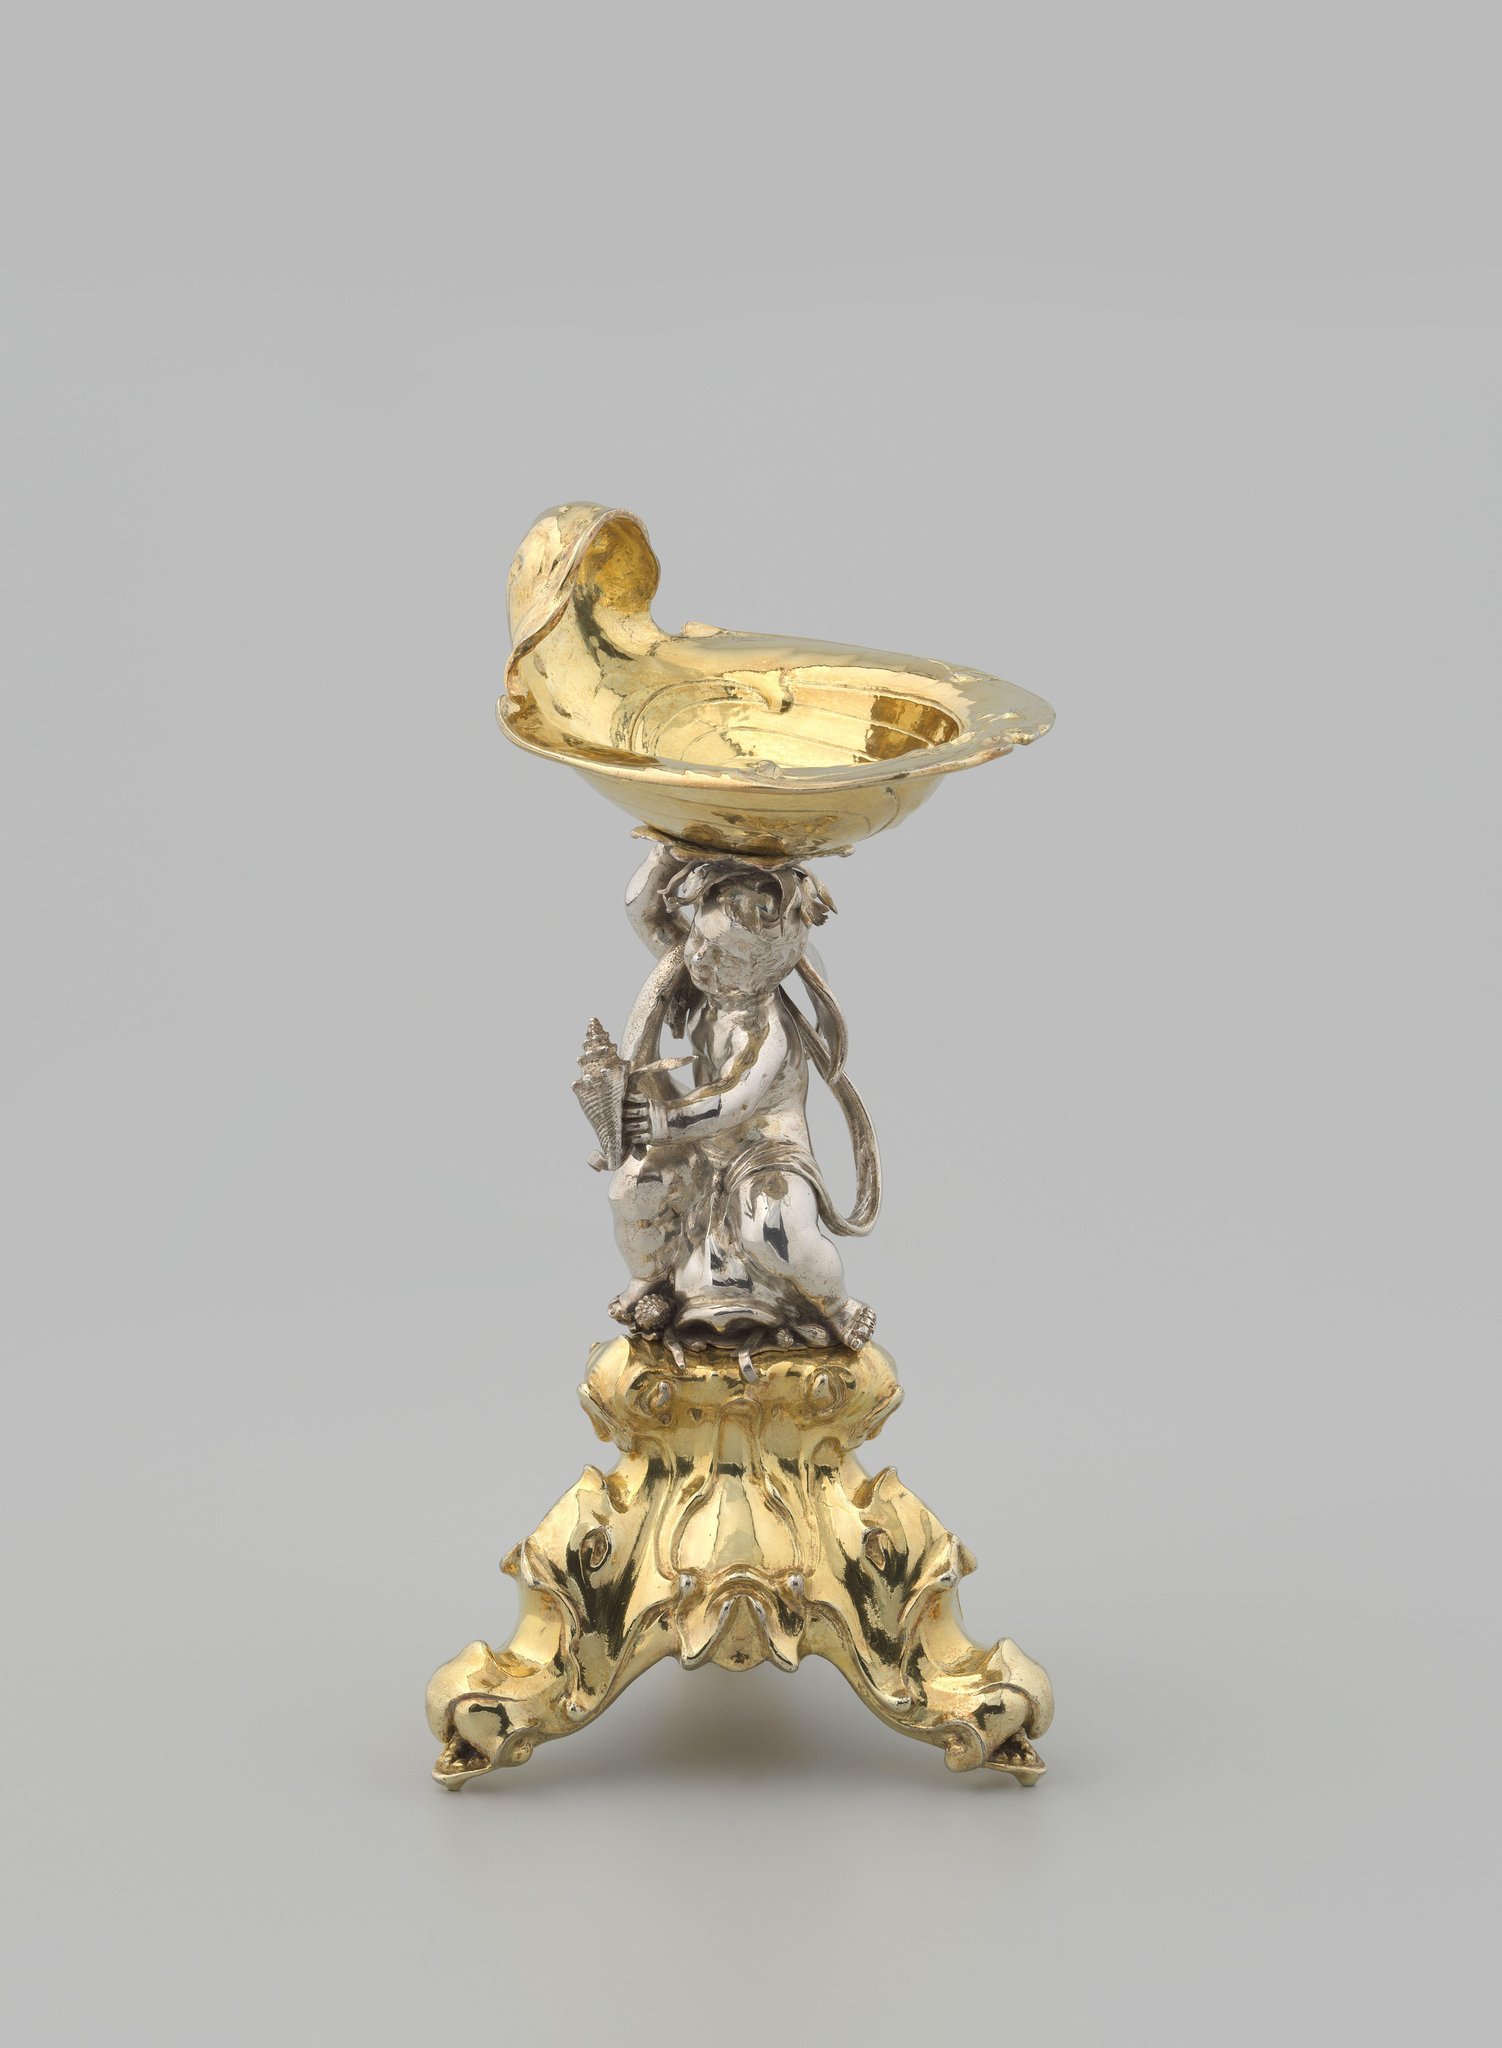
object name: salt condiment vessel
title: Two Salt Cellars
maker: johannes lutma (1584-1669)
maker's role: draughtsman, print maker, silversmith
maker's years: 1584-1669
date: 1639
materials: silver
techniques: gilding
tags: ornament derived from animal forms, dolphin ~ ornament, scallop, shell ~ ornament, cupids: 'amores', 'amoretti', 'putti'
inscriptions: date letter: ‘H’, maker's mark, town mark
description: These salt cellars showcase the artistic influences Johannes Lutma absorbed while in Rome in 1630. Already in Roman antiquity, children were a favourite motif in sculpture, new variants of which sculptors developed in Lutma’s time. Lutma, too, created his own version, incorporating it into his salt cellars. The figure of the child follows the classical idiom, skilfully combined with fanciful auricular ornaments adorning the pedestal and bowl.